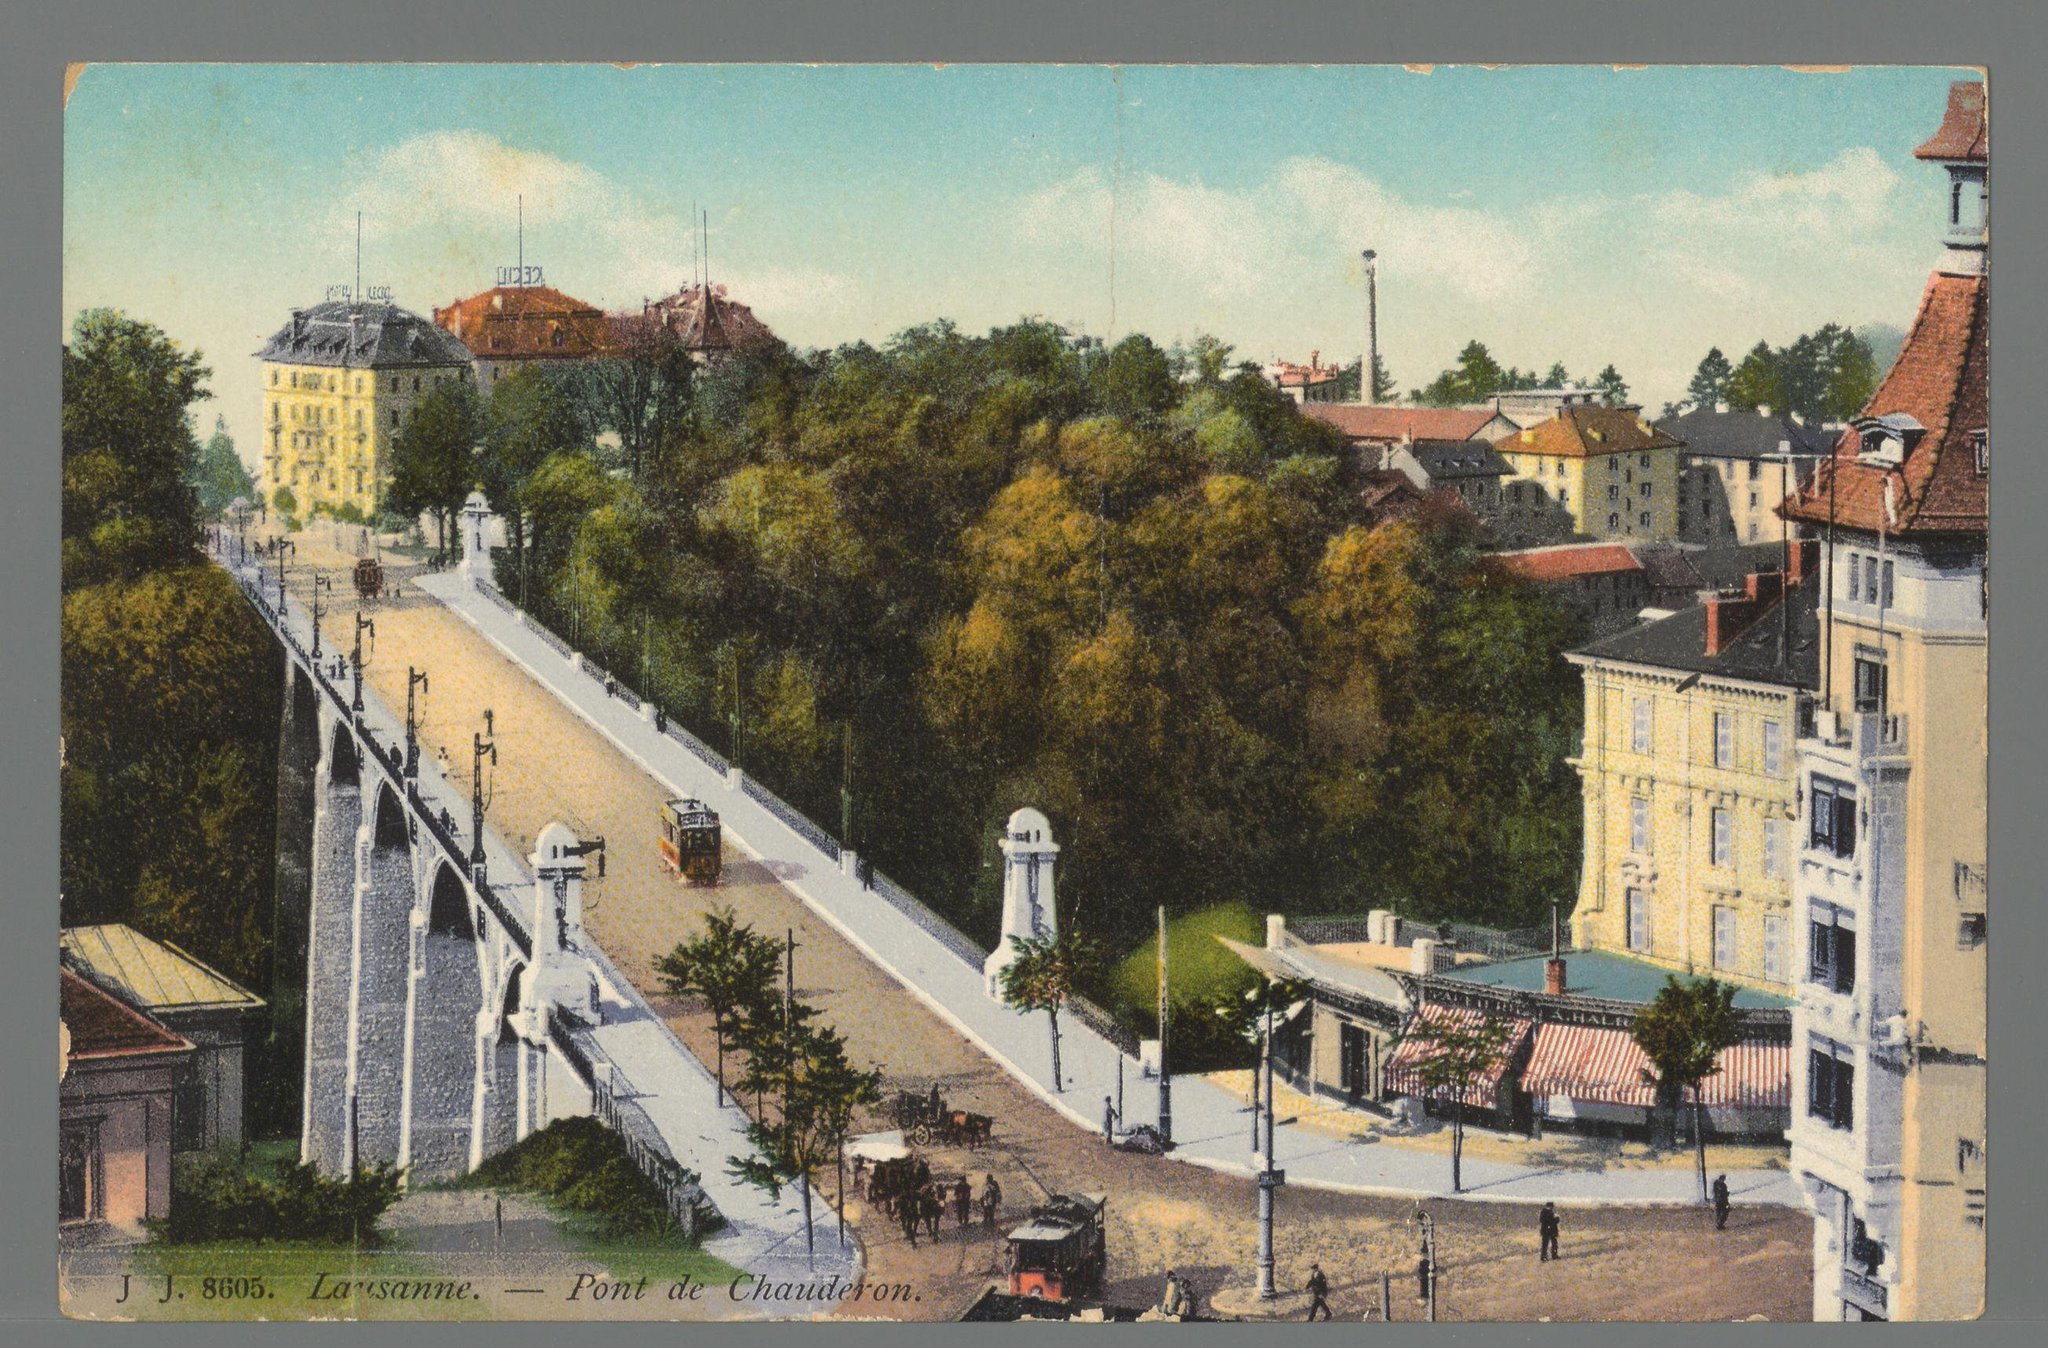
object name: ansichtkaart, prentbriefkaart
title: Lausanne. Pont de Chauderon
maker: Anonymous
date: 1905-1918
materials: cardboard, photographic process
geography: lausanne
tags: bridge, city-view, and landscape with man-made constructions (+ city(-scape) with figures, staffage)